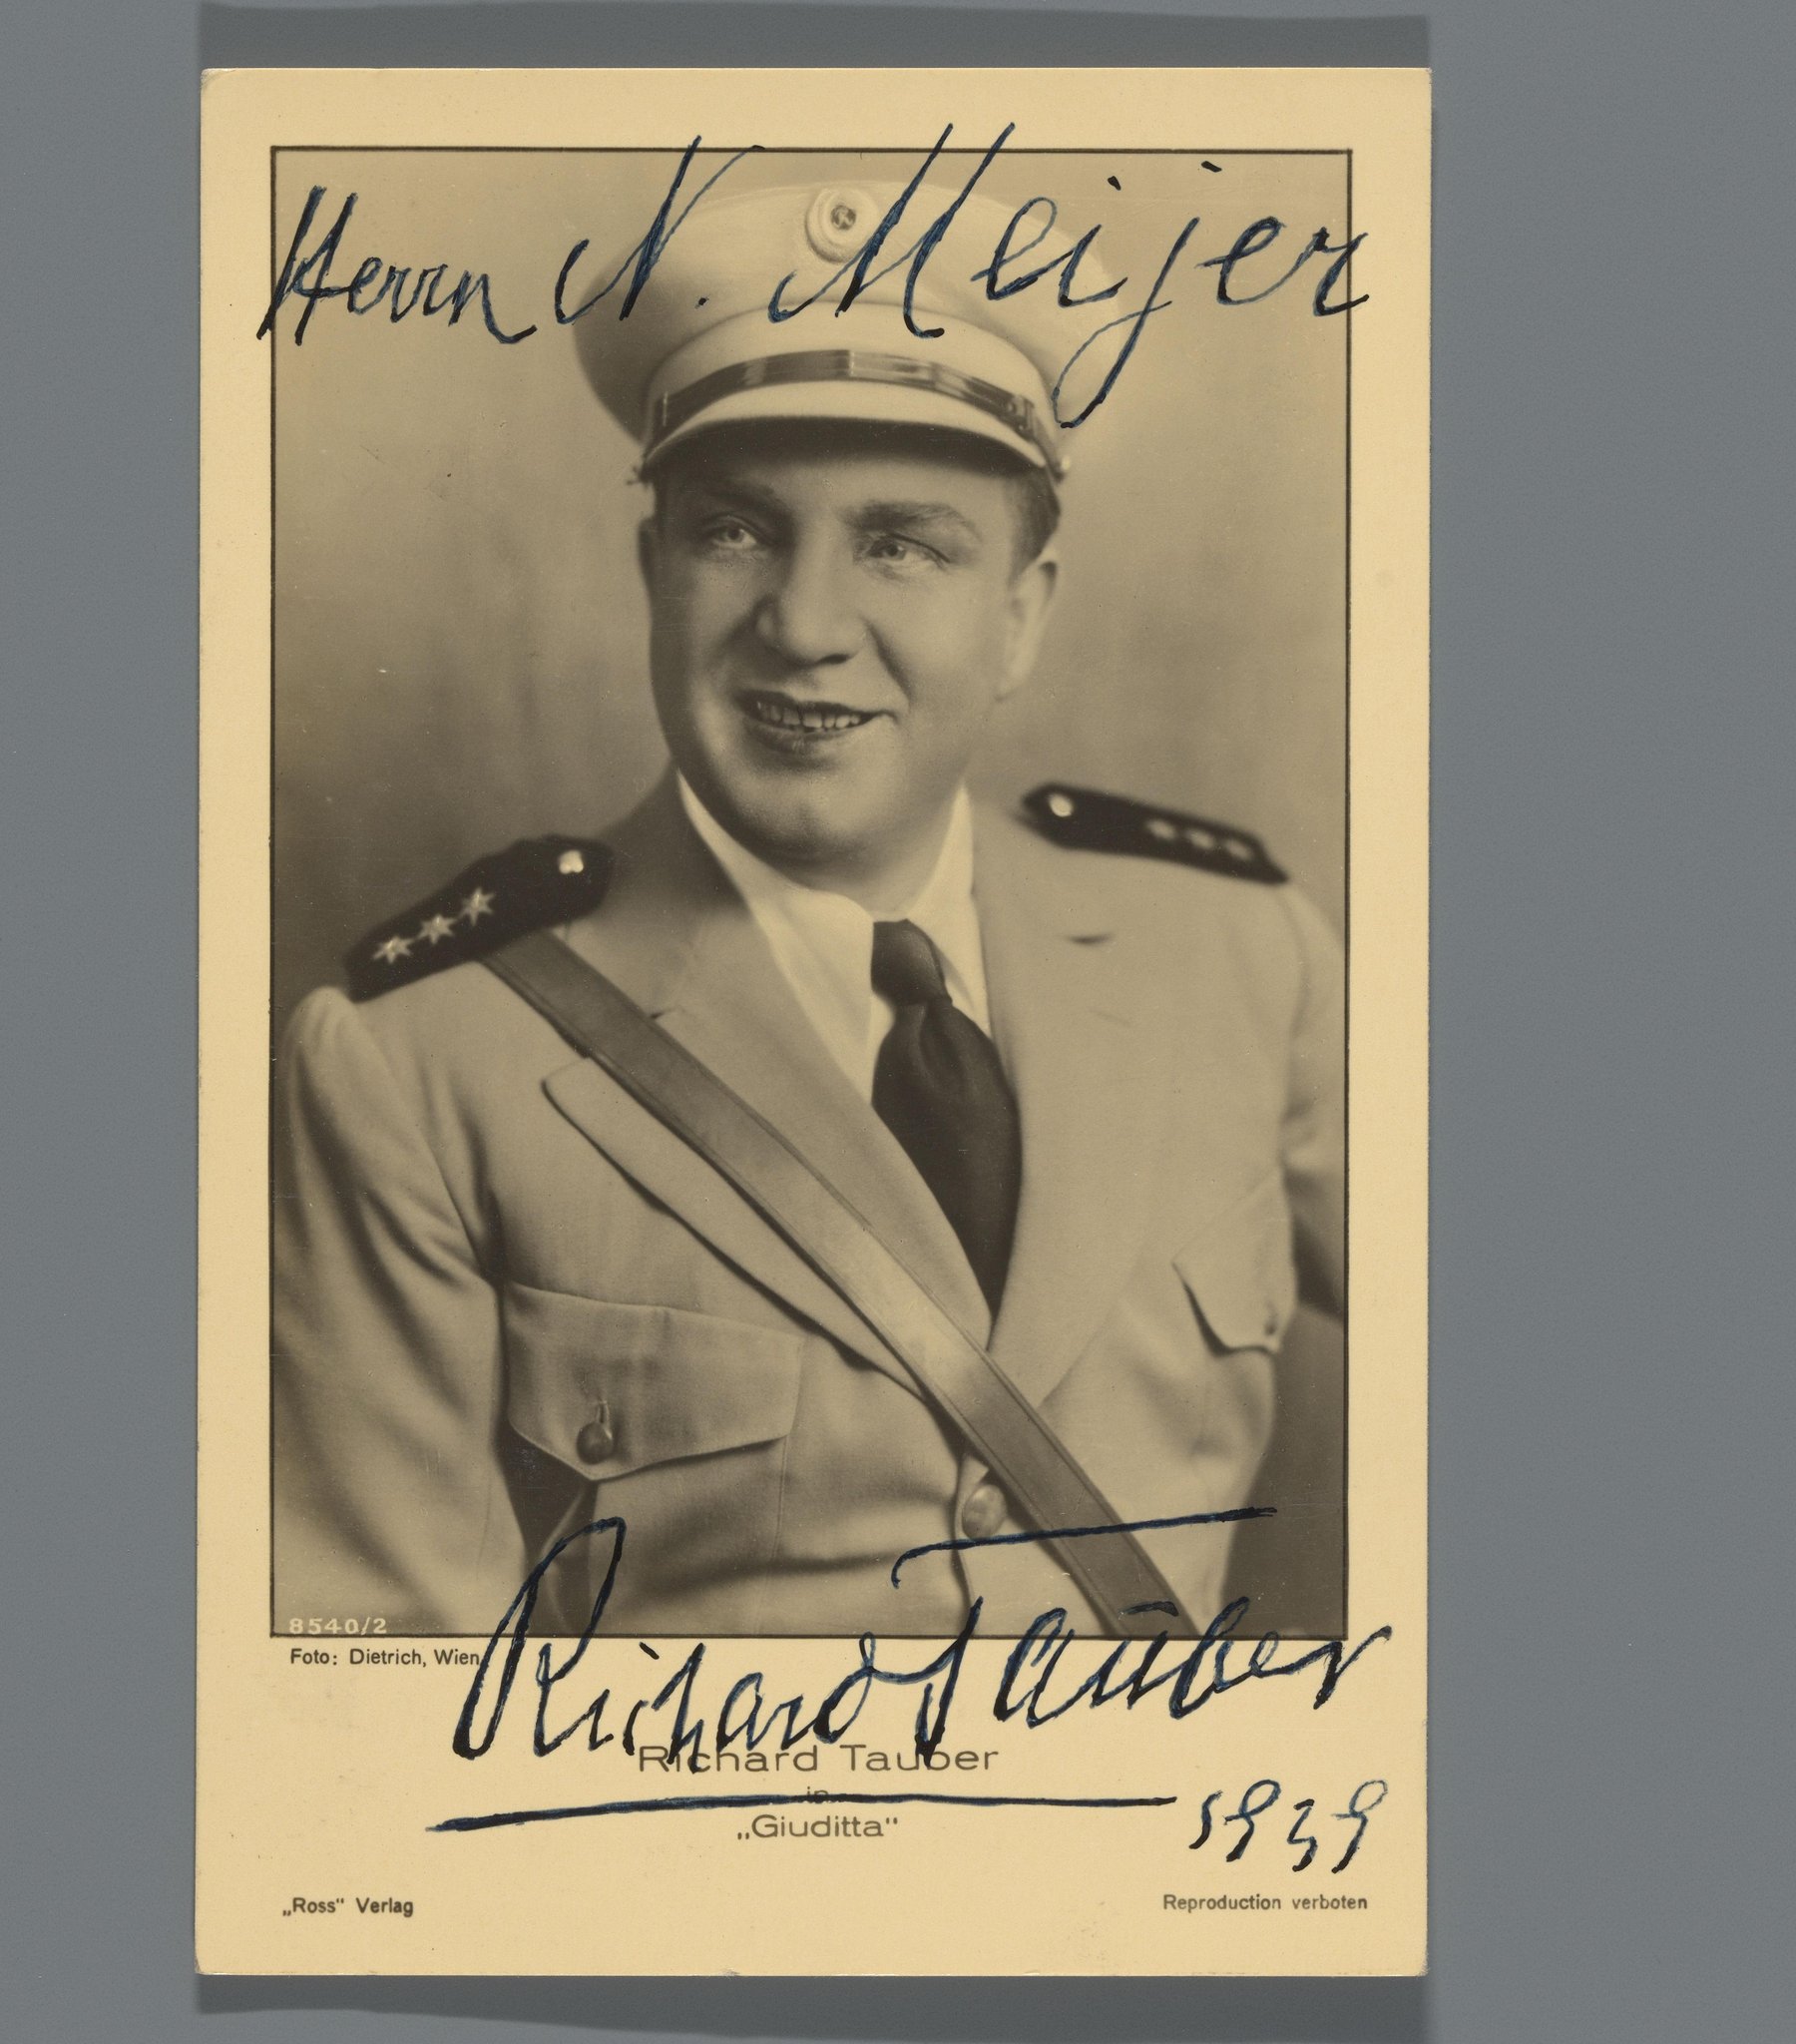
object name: ansichtkaart, prentbriefkaart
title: Portret van Richard Tauber als Octavio in Giuditta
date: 1934-1939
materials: paper, ink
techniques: gelatin silver print, pen, writing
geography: vienna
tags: portrait of opera-singer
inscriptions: name: ‘Harm N. Meijer’, signature: ‘Richard Tauber/ 1939’, number: ‘8540/2’